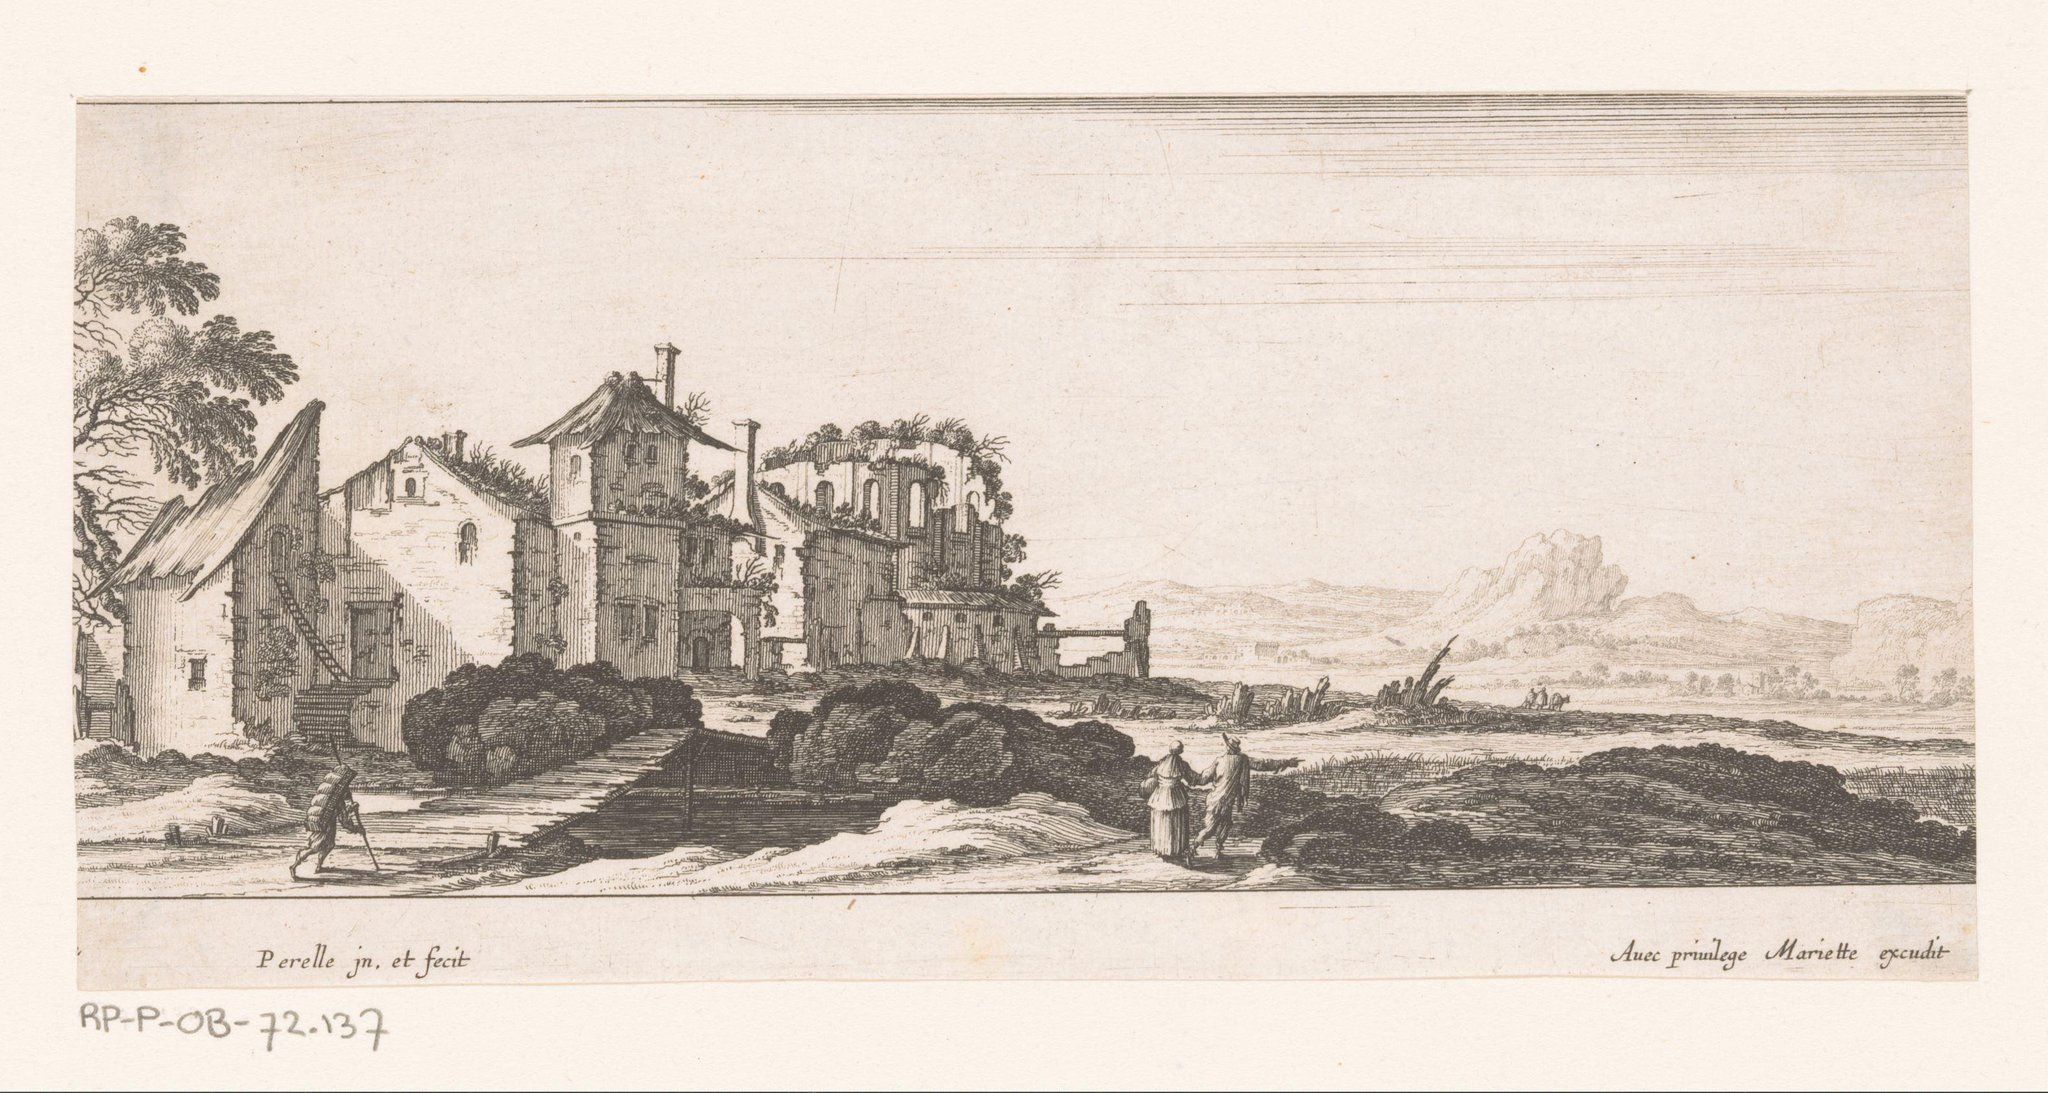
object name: print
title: Landschap met huizen en ruïnes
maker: pierre mariette (i)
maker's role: print maker, publisher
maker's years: 1596-1657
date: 1613-1657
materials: paper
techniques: etching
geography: paris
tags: landscape with ruins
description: Prenten met het signatuur 'Perelle' kunnen zowel door vader Gabriel als door zonen Nicolas en Adam gemaakt zijn.